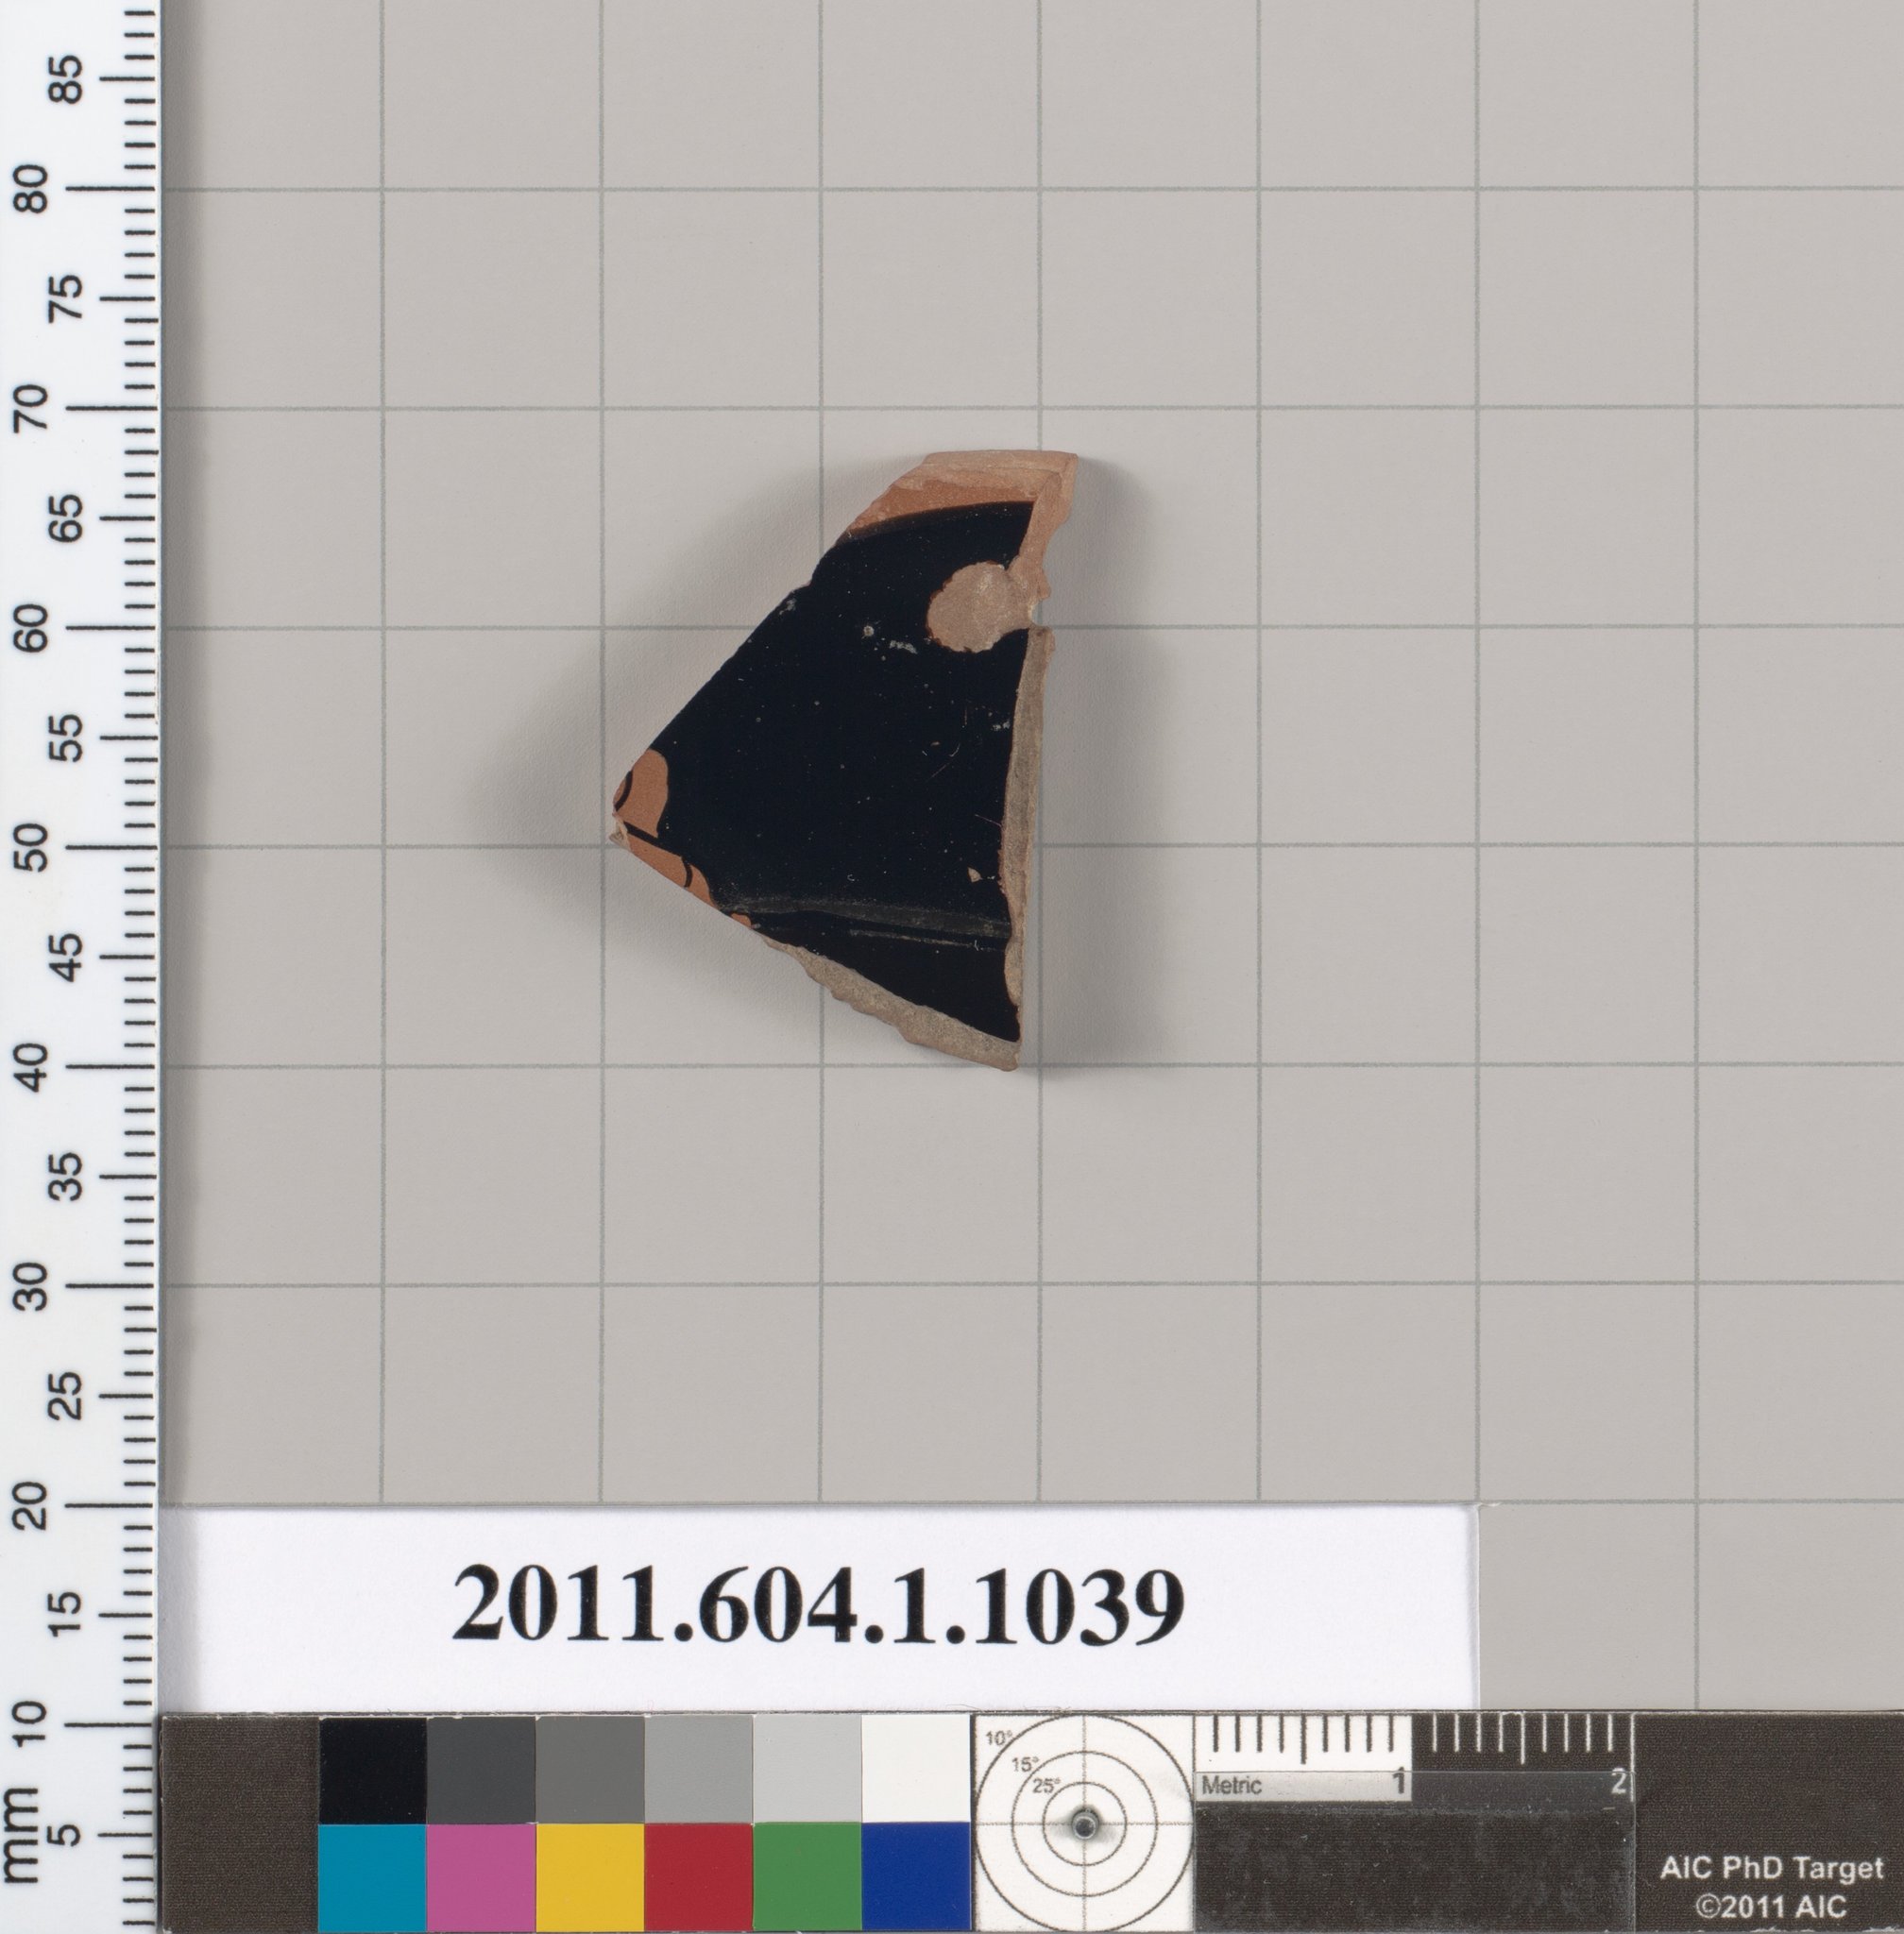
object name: kylix fragment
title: Terracotta fragment of a kylix (drinking cup)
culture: greek, attic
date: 475-451 BCE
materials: terracotta